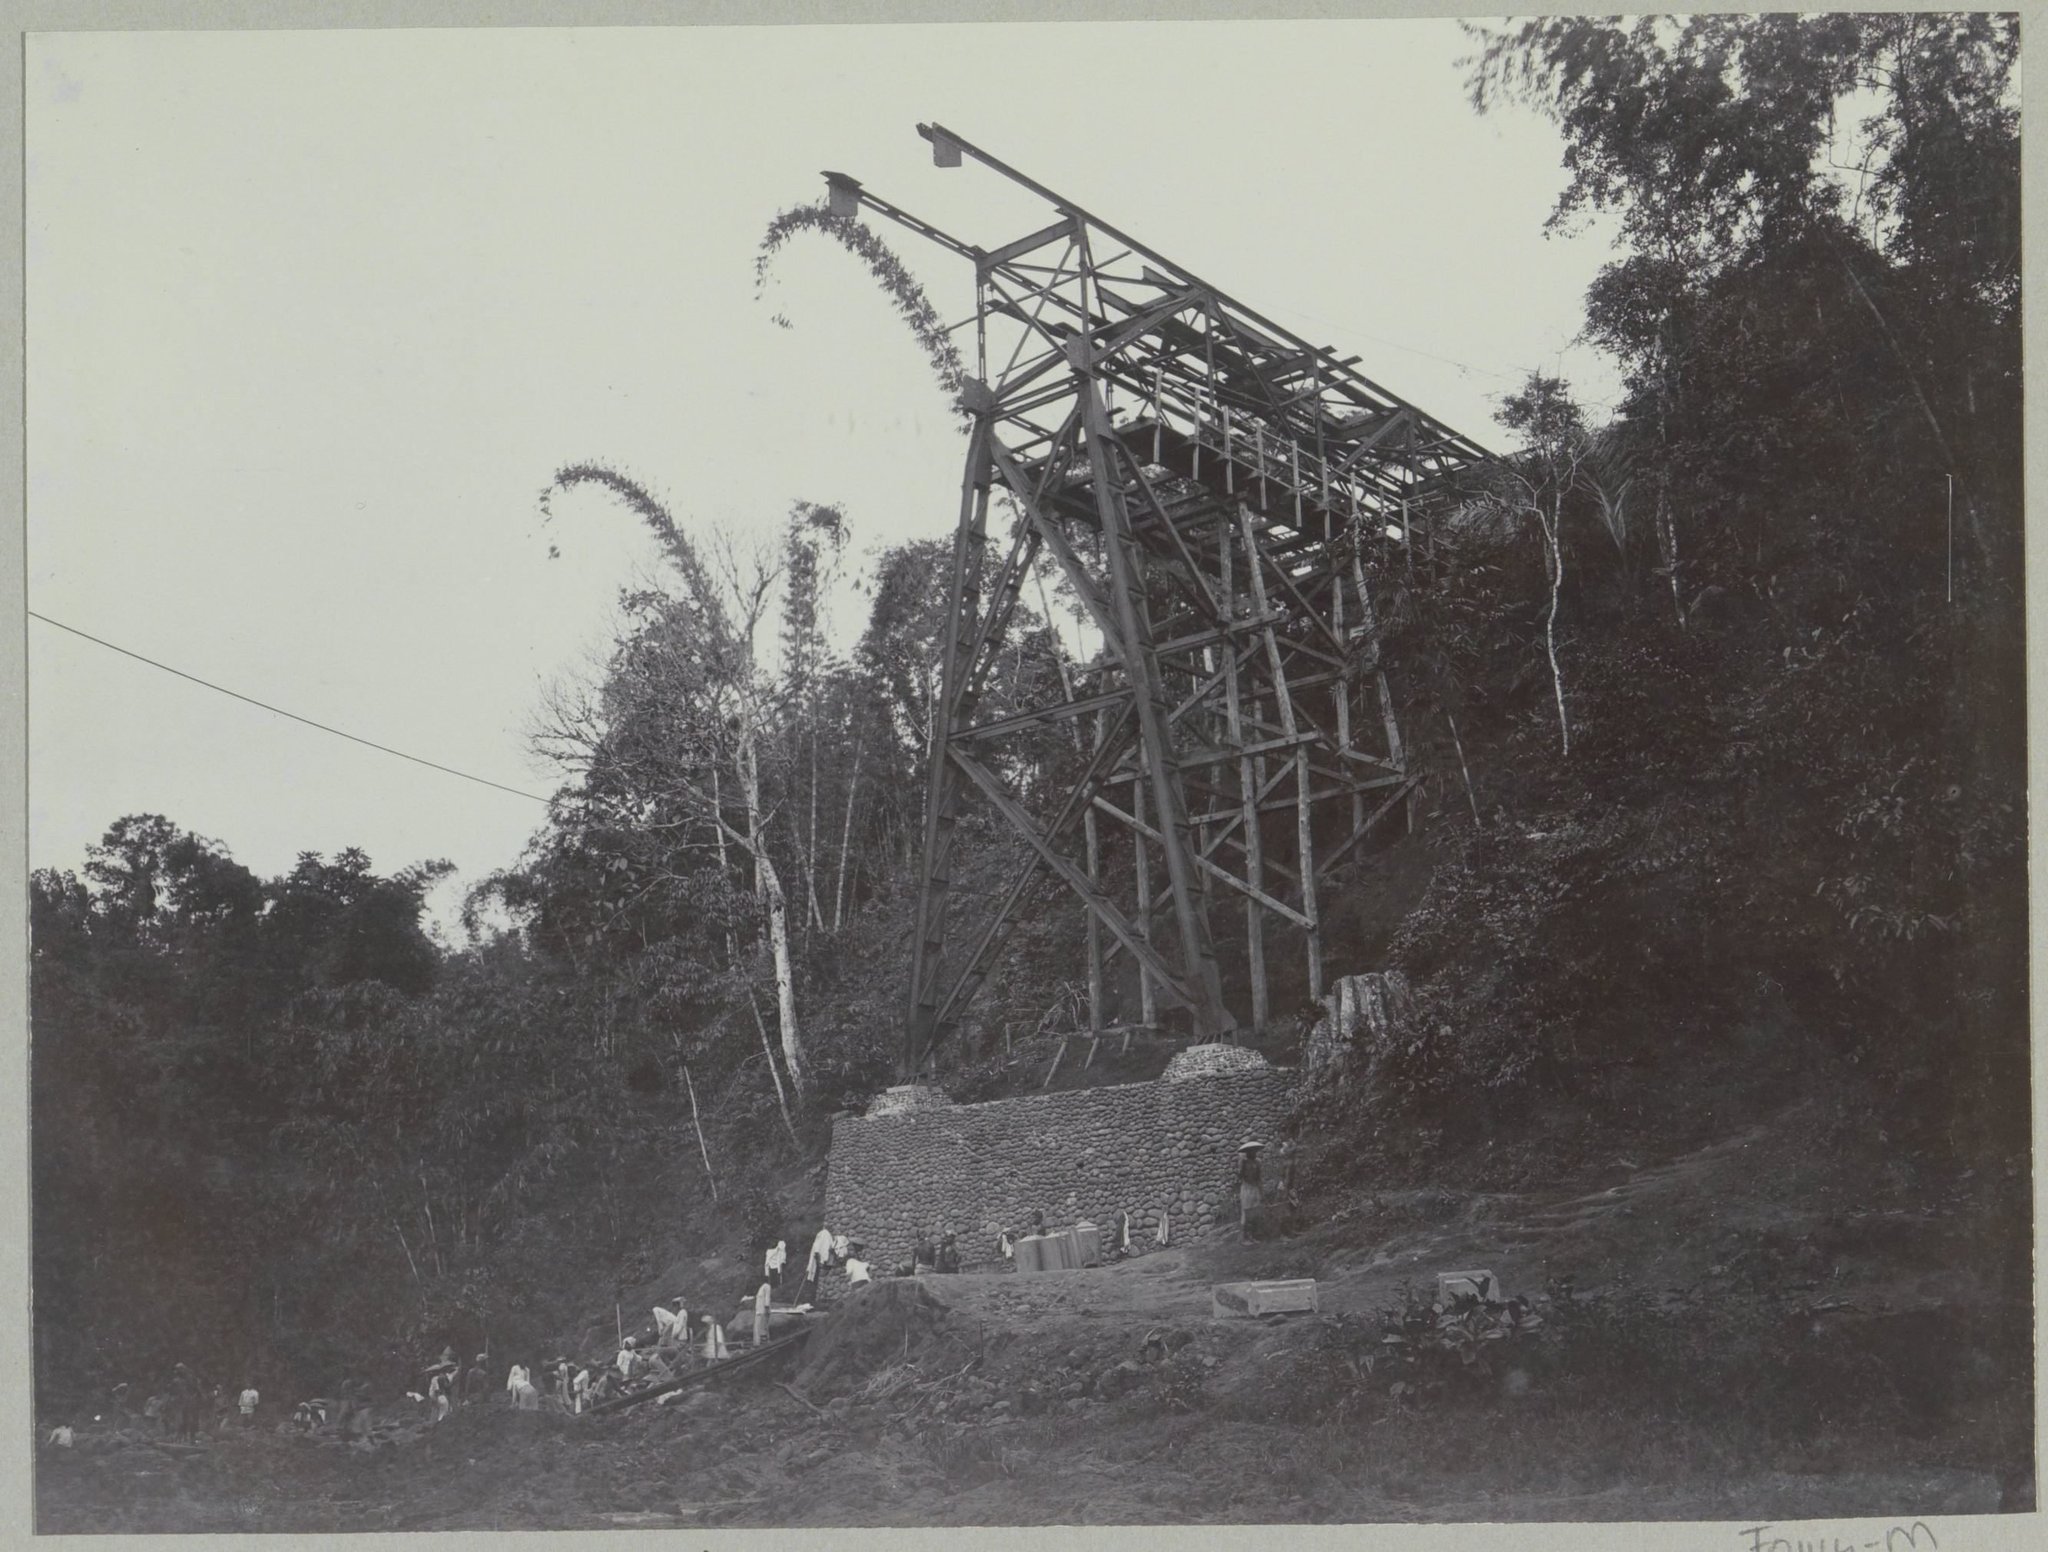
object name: photograph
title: Gereed landhoofd van brug met gemonteerde brugpijler en ijzerwerk op de oostelijke oever van de Kali Brantas ten zuiden van Malang (Photo XIII)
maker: Anonymous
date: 1890-1920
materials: cardboard, paper, photographic support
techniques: gelatin silver print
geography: java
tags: engineering, landscape with bridge, viaduct or aqueduct, bridge, building-site, java, dutch east indies, the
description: Foto met op de linkerpagina het bijbehorende bijschrift. Onderdeel van Fotoalbum met opnames van de bouw van een brug over de Kali Brantas ten zuiden van Malang op Java.